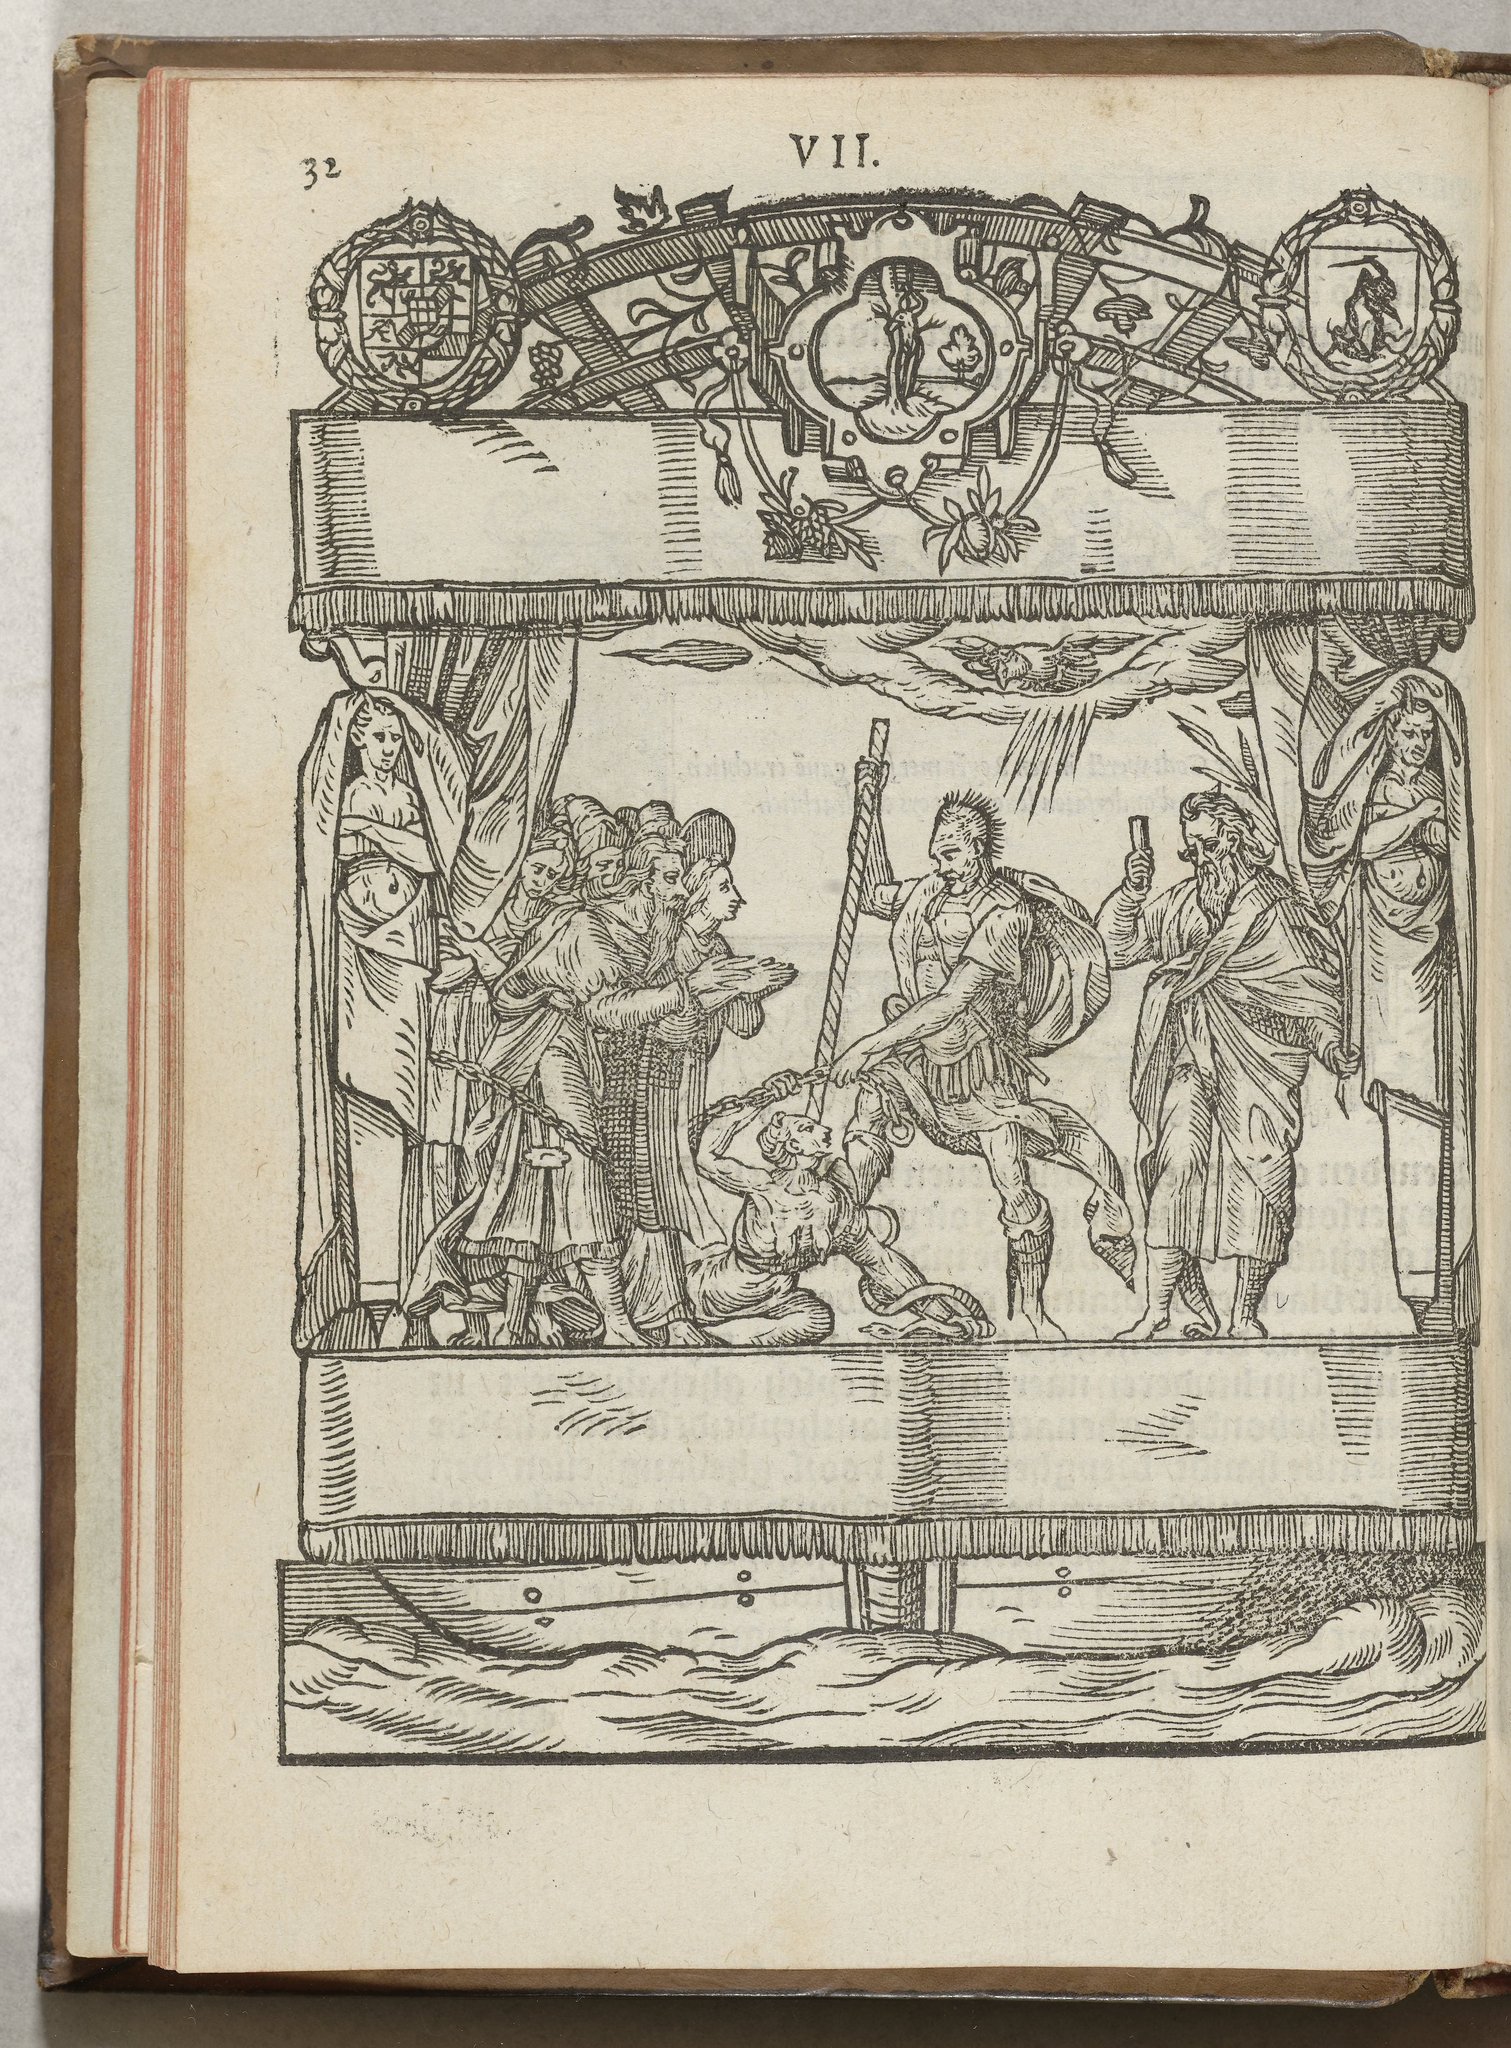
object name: print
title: De voorstelling van De Corenbloem: Jozef overwint Tweedracht, 1577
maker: antoni van leest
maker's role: print maker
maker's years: 1545-1592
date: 1577-1578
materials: paper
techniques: woodcut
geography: netherlands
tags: delft, william i (prince of orange), group of actors, troupe; actors on the stage, triumphal entry and public reception, pageant, 'entrée solennelle', 'joyeuse entrée', joseph (not in biblical context), brussels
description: Illustratie in: J. B. Houwaert, Declaratie van die triumphante incompst vande doorluchtighen ende hoogheboren Prine van Oraingnien, binnen die princelijcke stadt van Brussele, geschiet in t' iaer ... 1578, den 18 Septembris, Christoffel Plantijn, Antwerpen 1579. Boek in de bibliotheek met signatuur: 325 D 29.